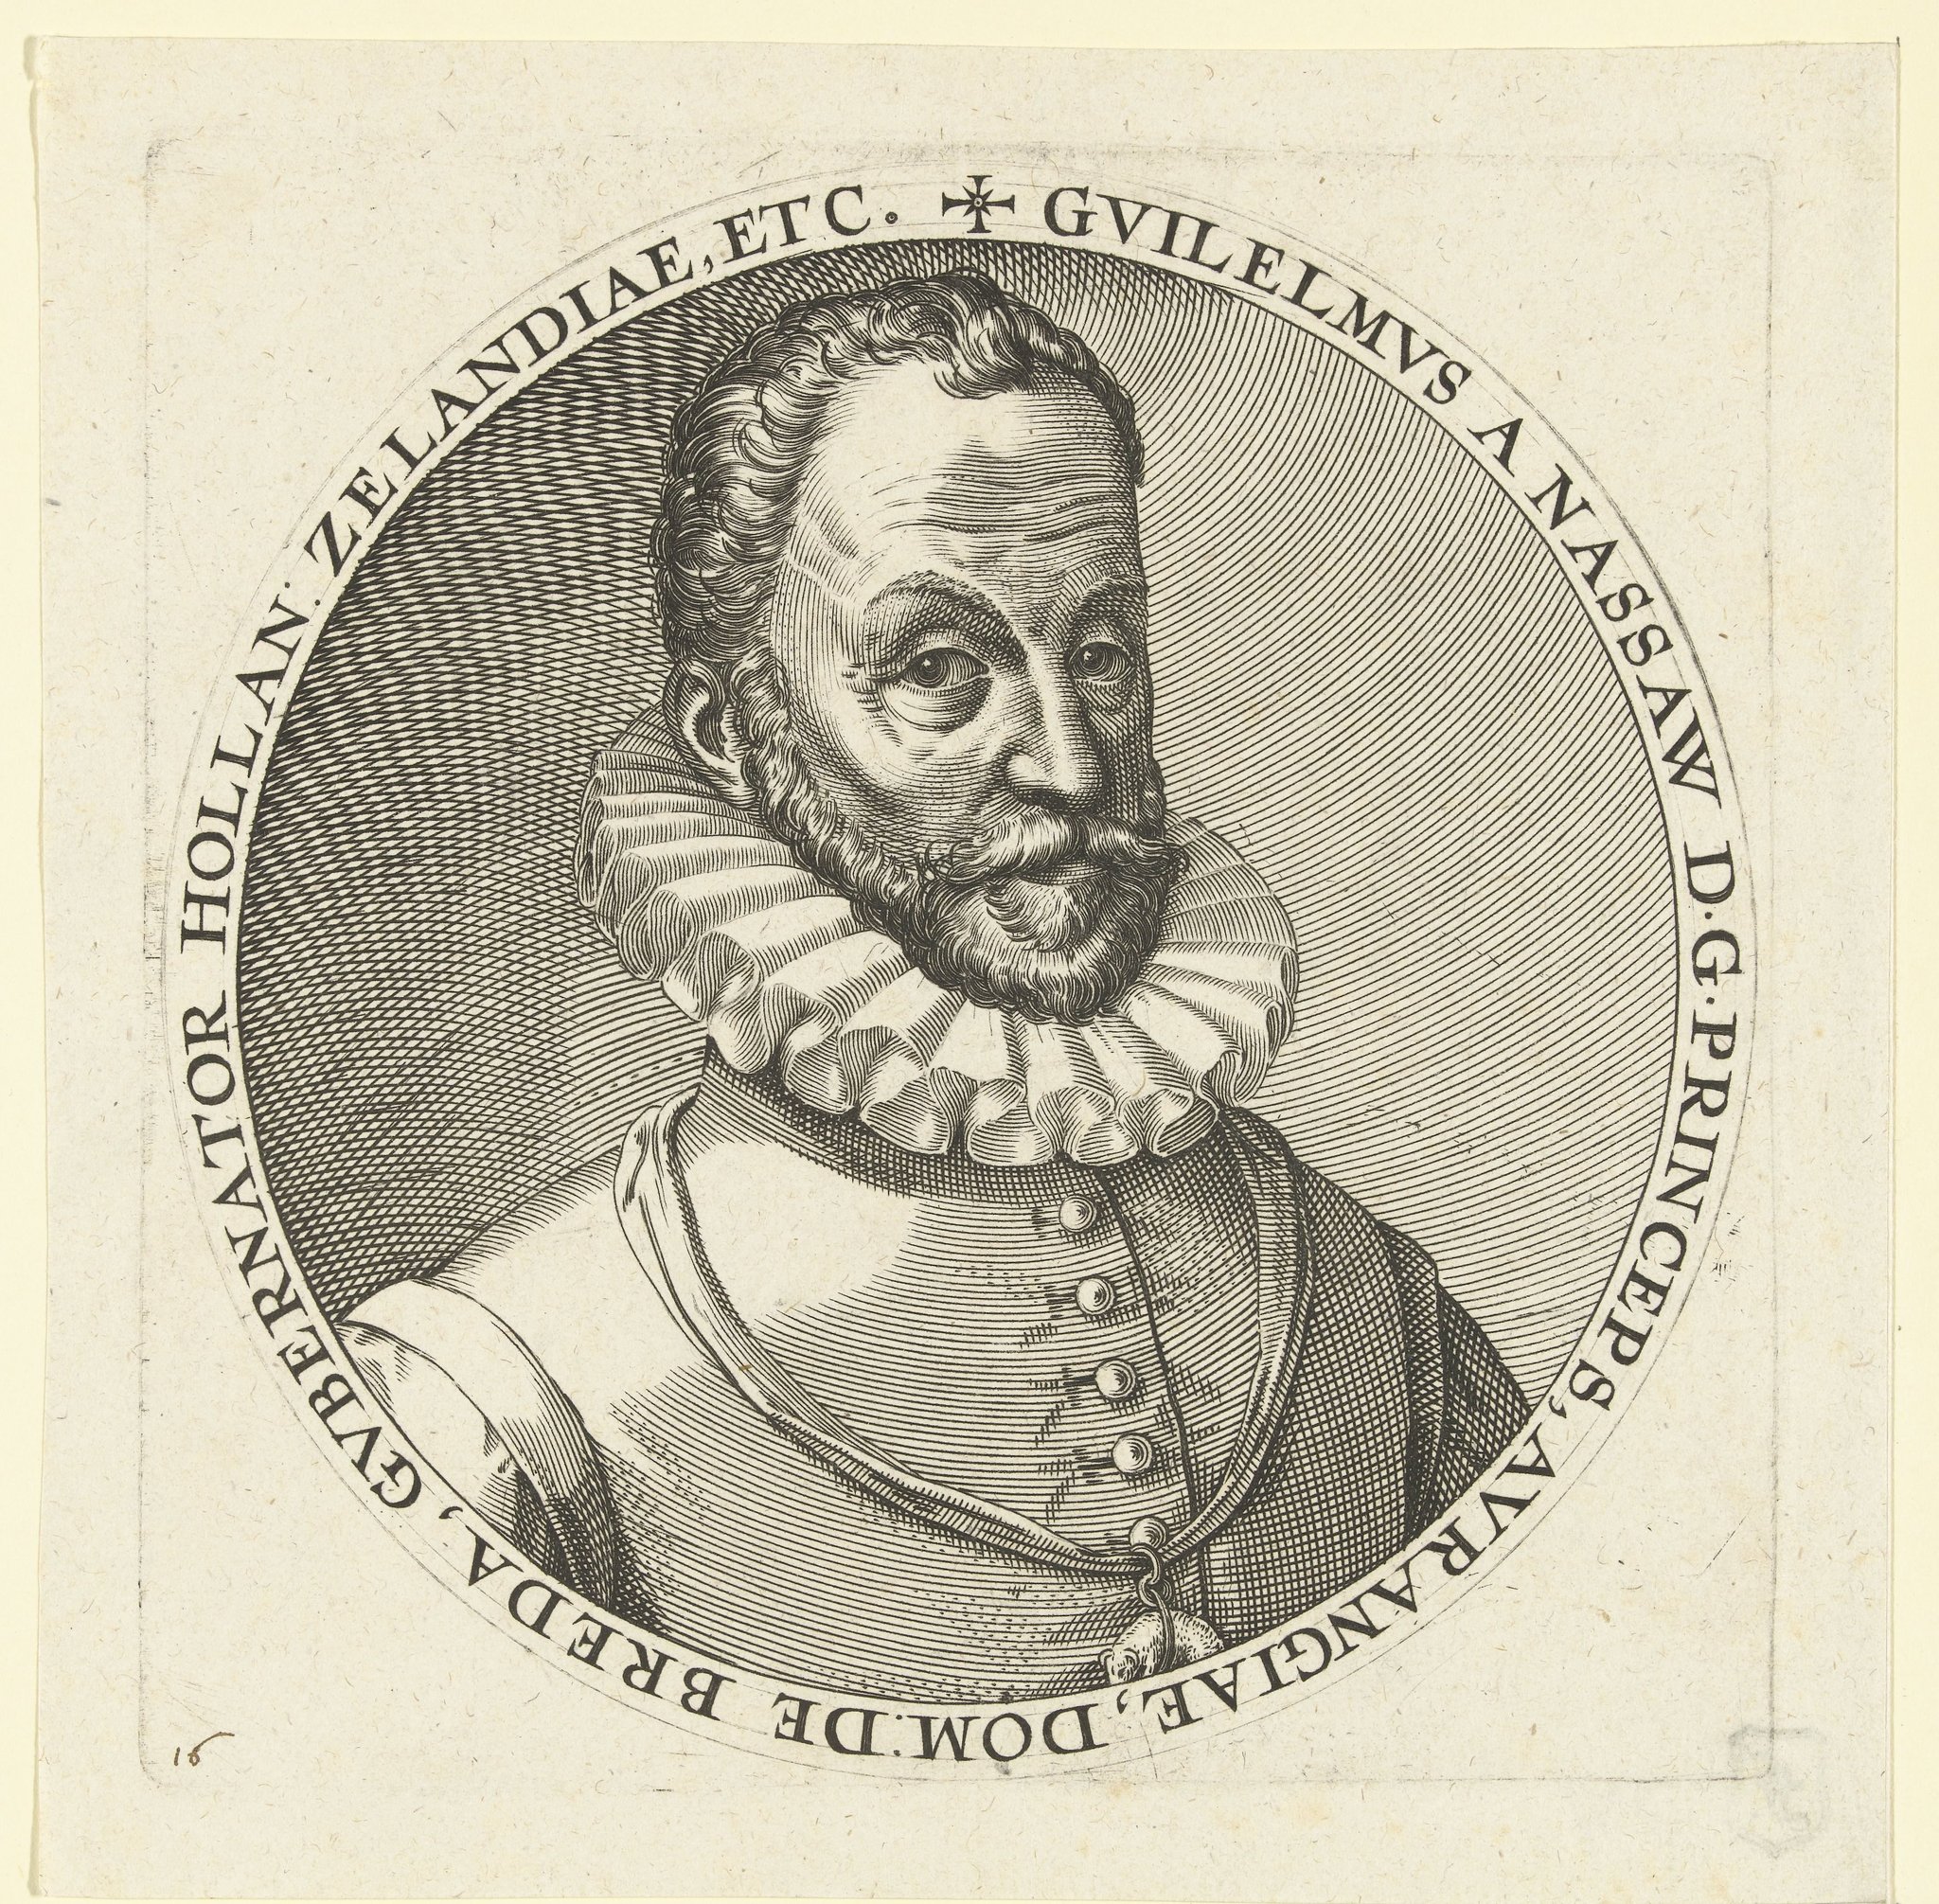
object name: print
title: Portret van Willem I, prins van Oranje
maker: Anonymous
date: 1603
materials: paper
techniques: engraving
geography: low countries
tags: william i (prince of orange), knighthood order of the golden fleece - insignia of a knighthood order, e.g.: badge, chain (with name of order)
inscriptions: collector's mark: Lugt 963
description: De hier vermelde titel verwijst naar de hoogst verkregen titel van de geportretteerde, niet per se naar de titel die de geportretteerde op deze voorstelling draagt. Kopie naar het origineel eerst gebruikt als illustratie in: Michael Aitsinger, Belgici leonis chorographia, das ist ein newe Landt Beschreibung des Belgischen Lewen, in 17 Provincien des gantzen Niderlandts außgetheylet. Keulen: Frans Hogenberg, 1587.